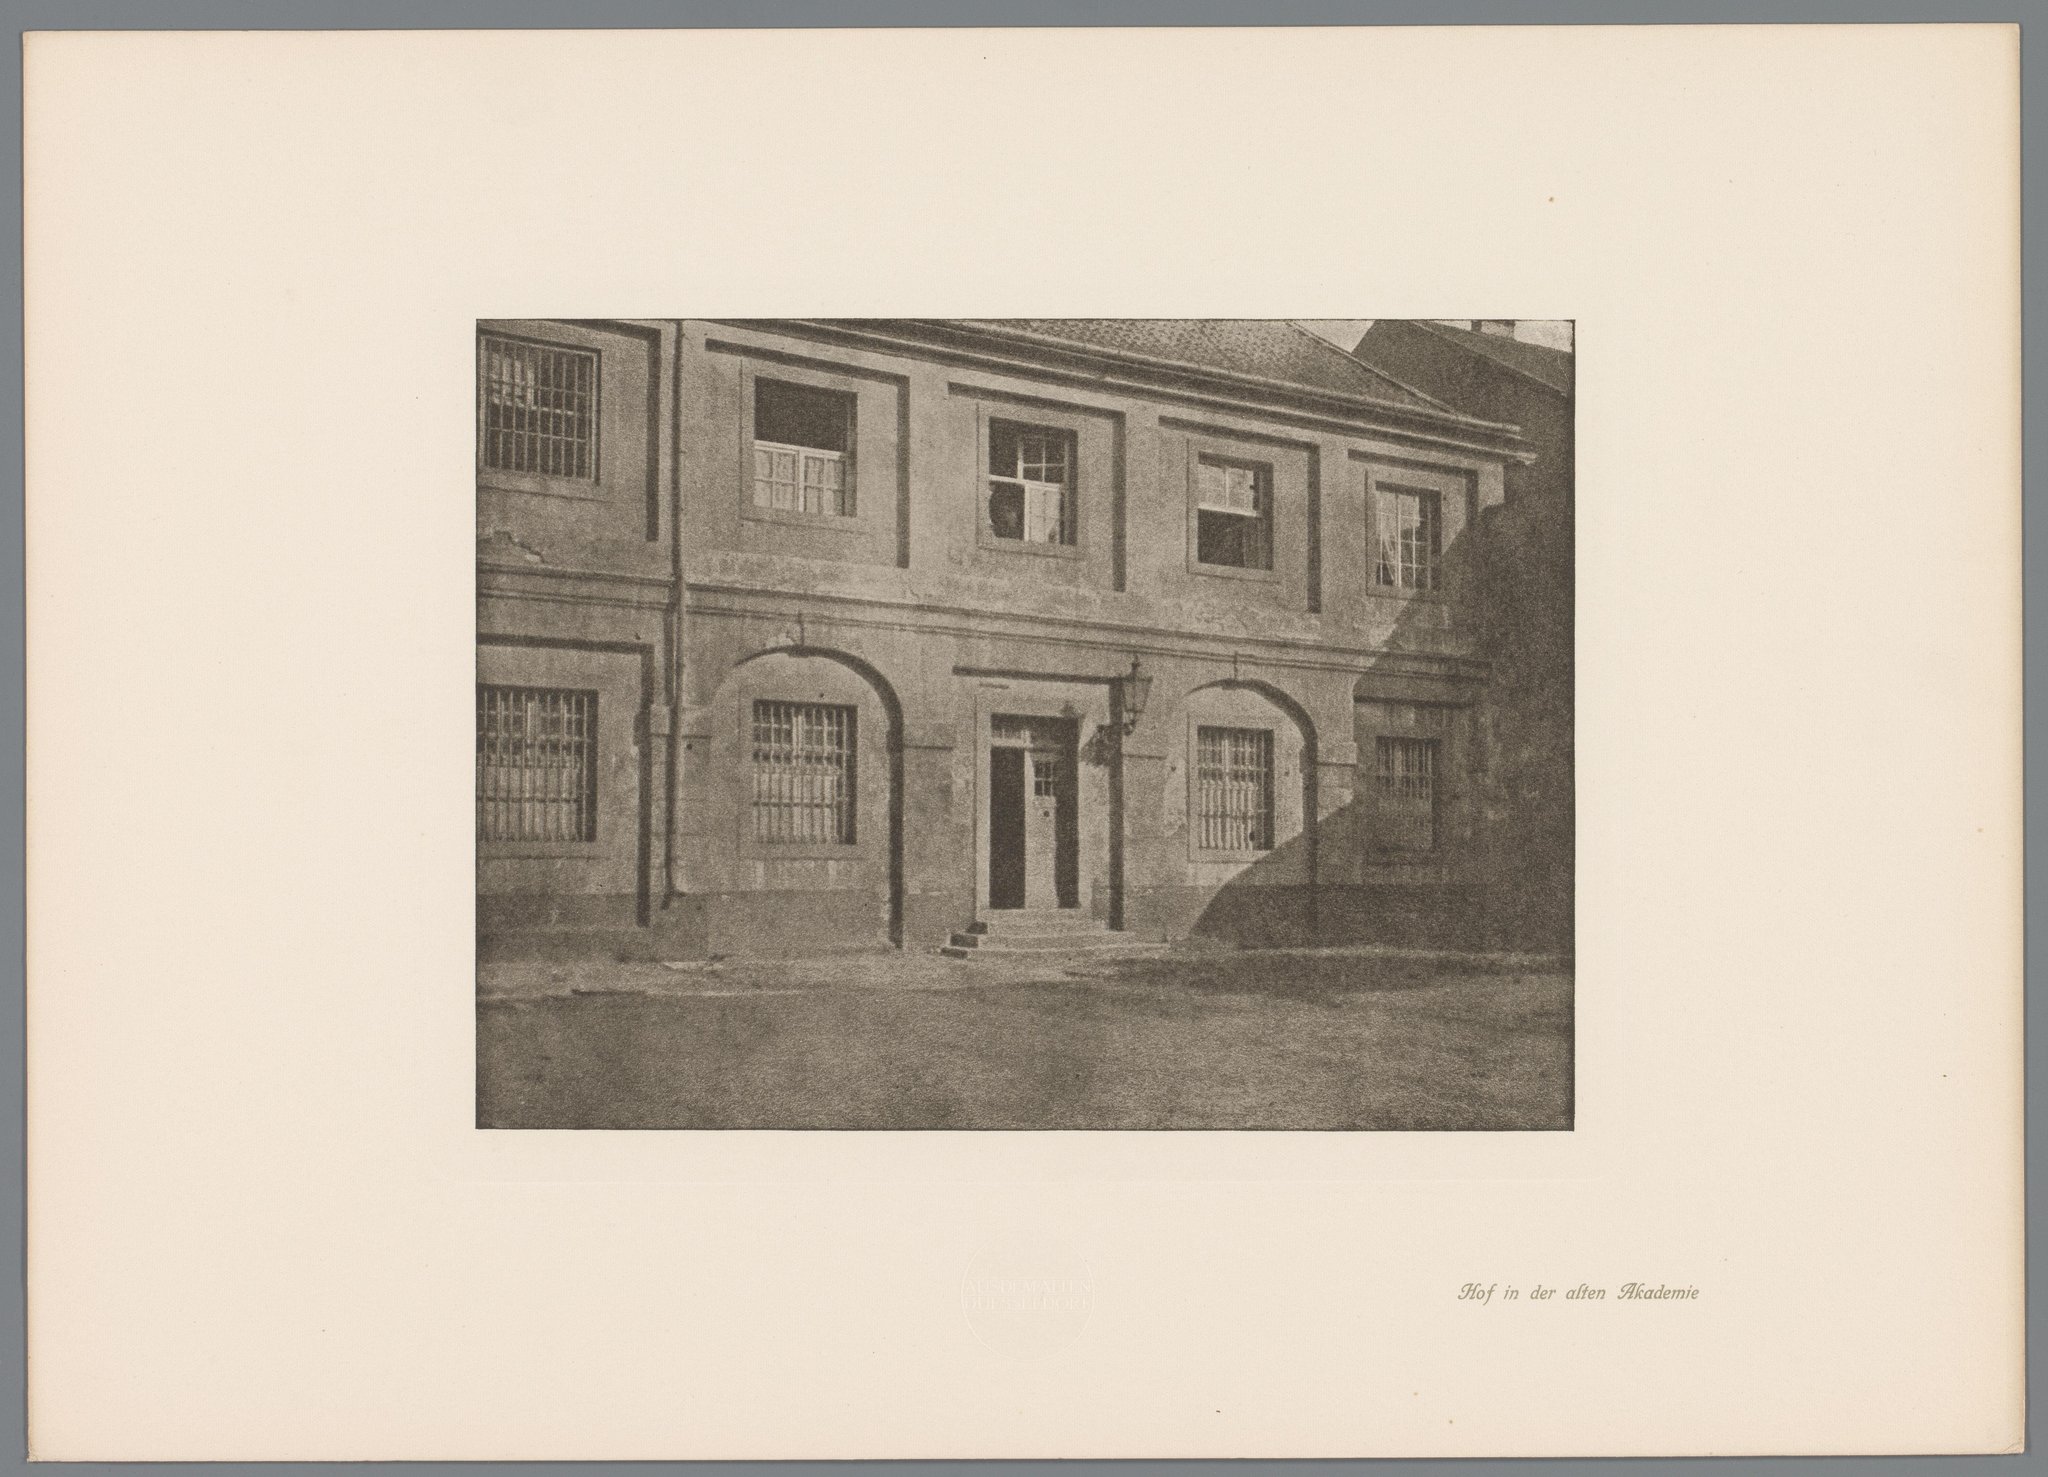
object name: page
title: Hof in der alten Akademie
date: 1902-1907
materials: paper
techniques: autotype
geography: dusseldorf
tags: courtyard, place or institution of education and training of the artist, e.g.: academy of art